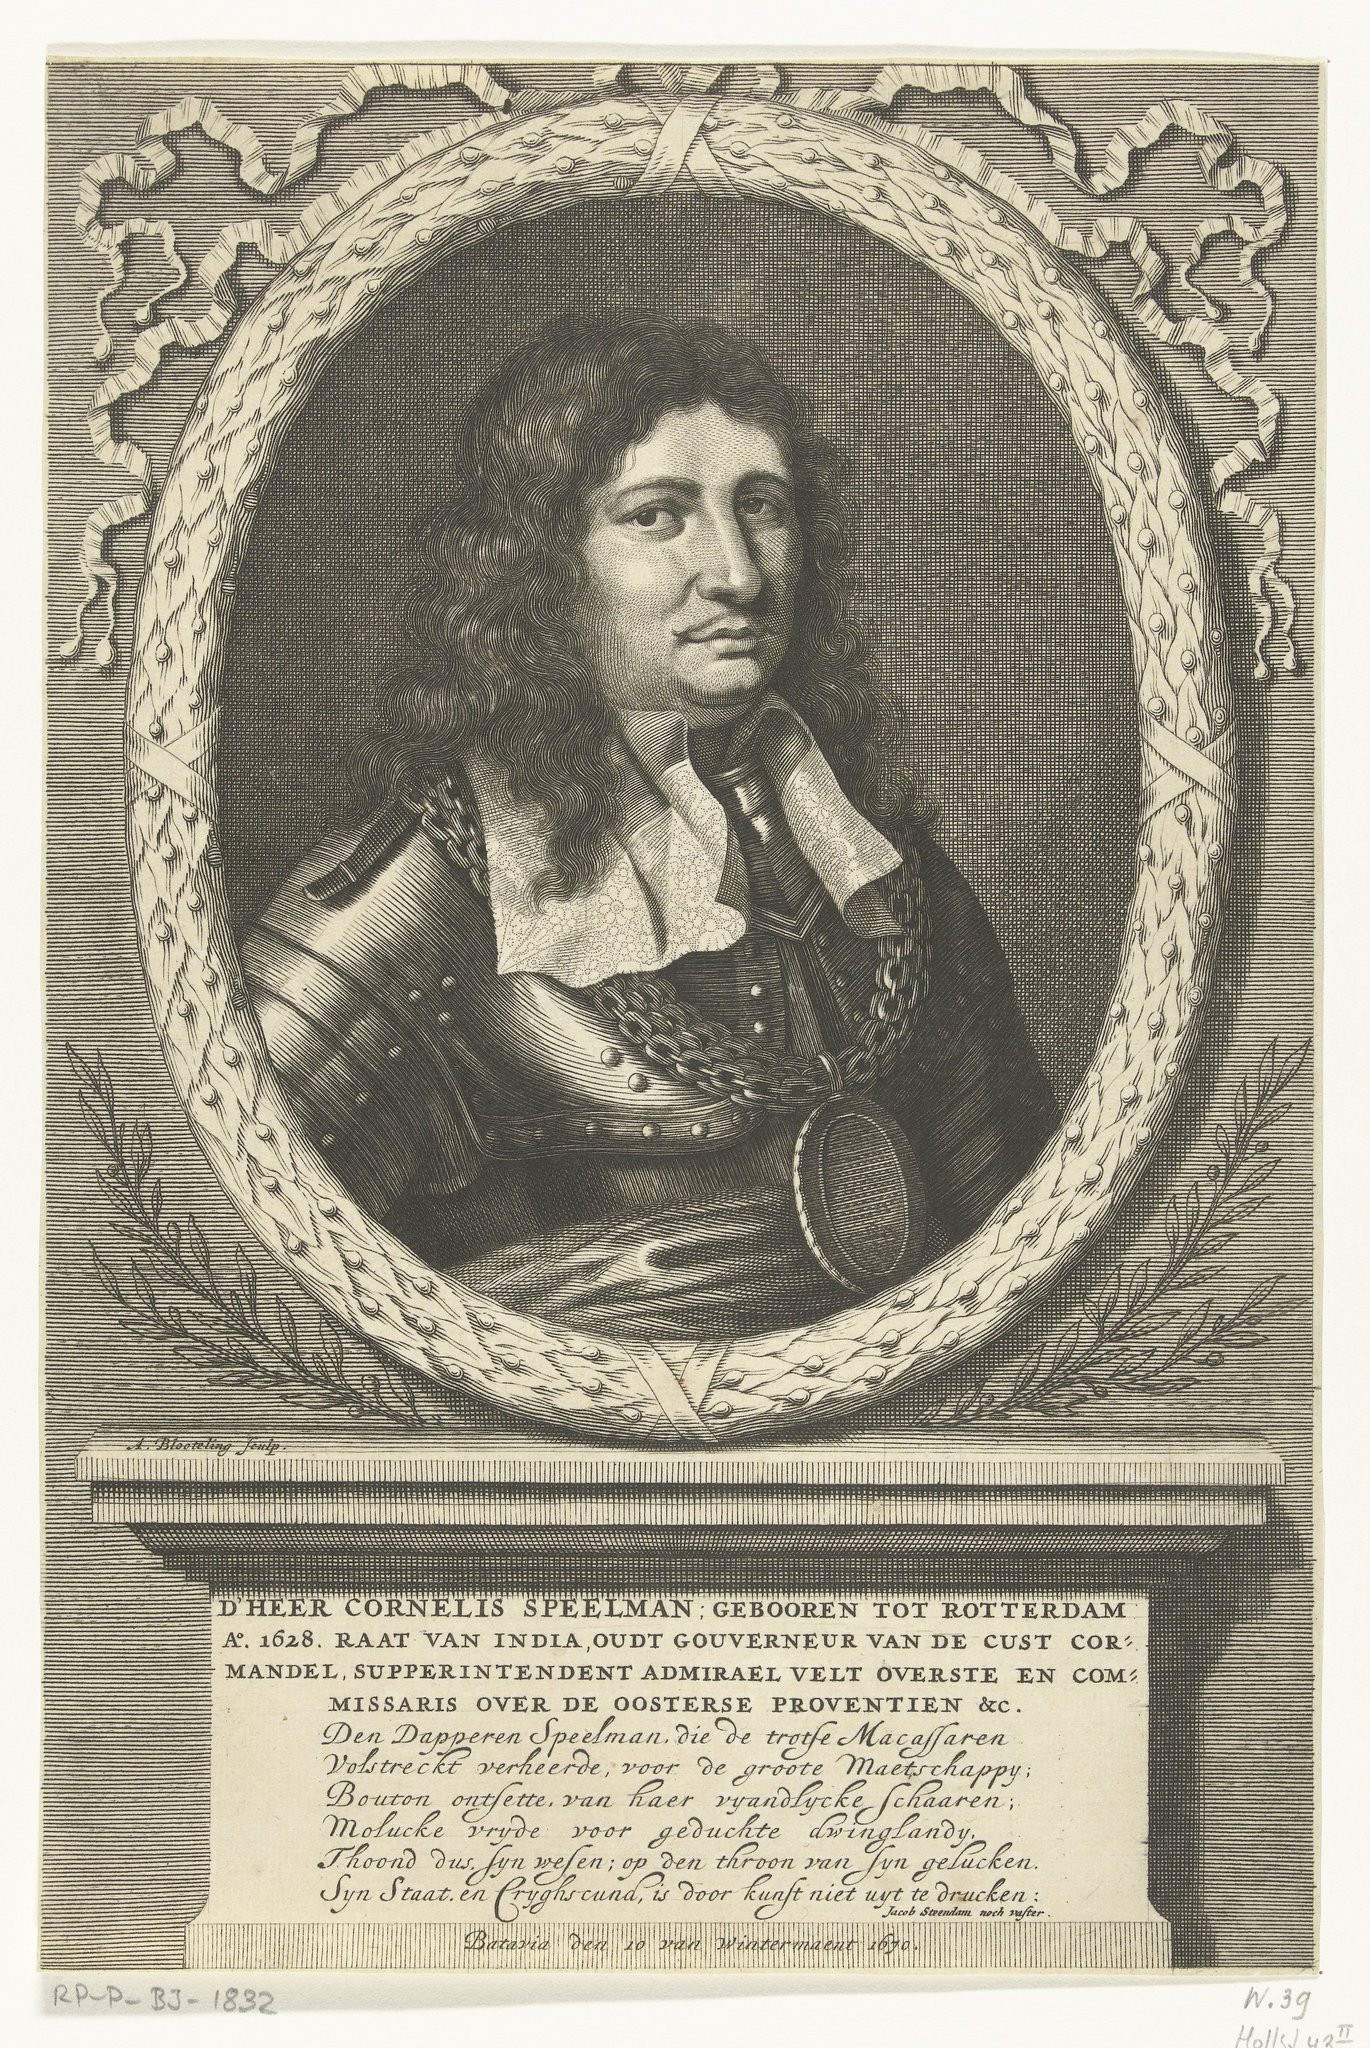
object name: print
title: Portret van Cornelis Speelman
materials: paper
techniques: engraving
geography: amsterdam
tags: rotterdam, batavia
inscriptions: collector's mark: Lugt 2228, collector's mark: Lugt 240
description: Borstbeeld van Cornelis Jansz. Speelman, gouverneur-generaal van de VOC. Speelman draagt de ketting met gouden medaille die hij heeft ontvangen voor de succesvolle onderwerping van de provincie Makassar op het eiland Celebes. Onder het portret een vers over de gebeurtenissen.